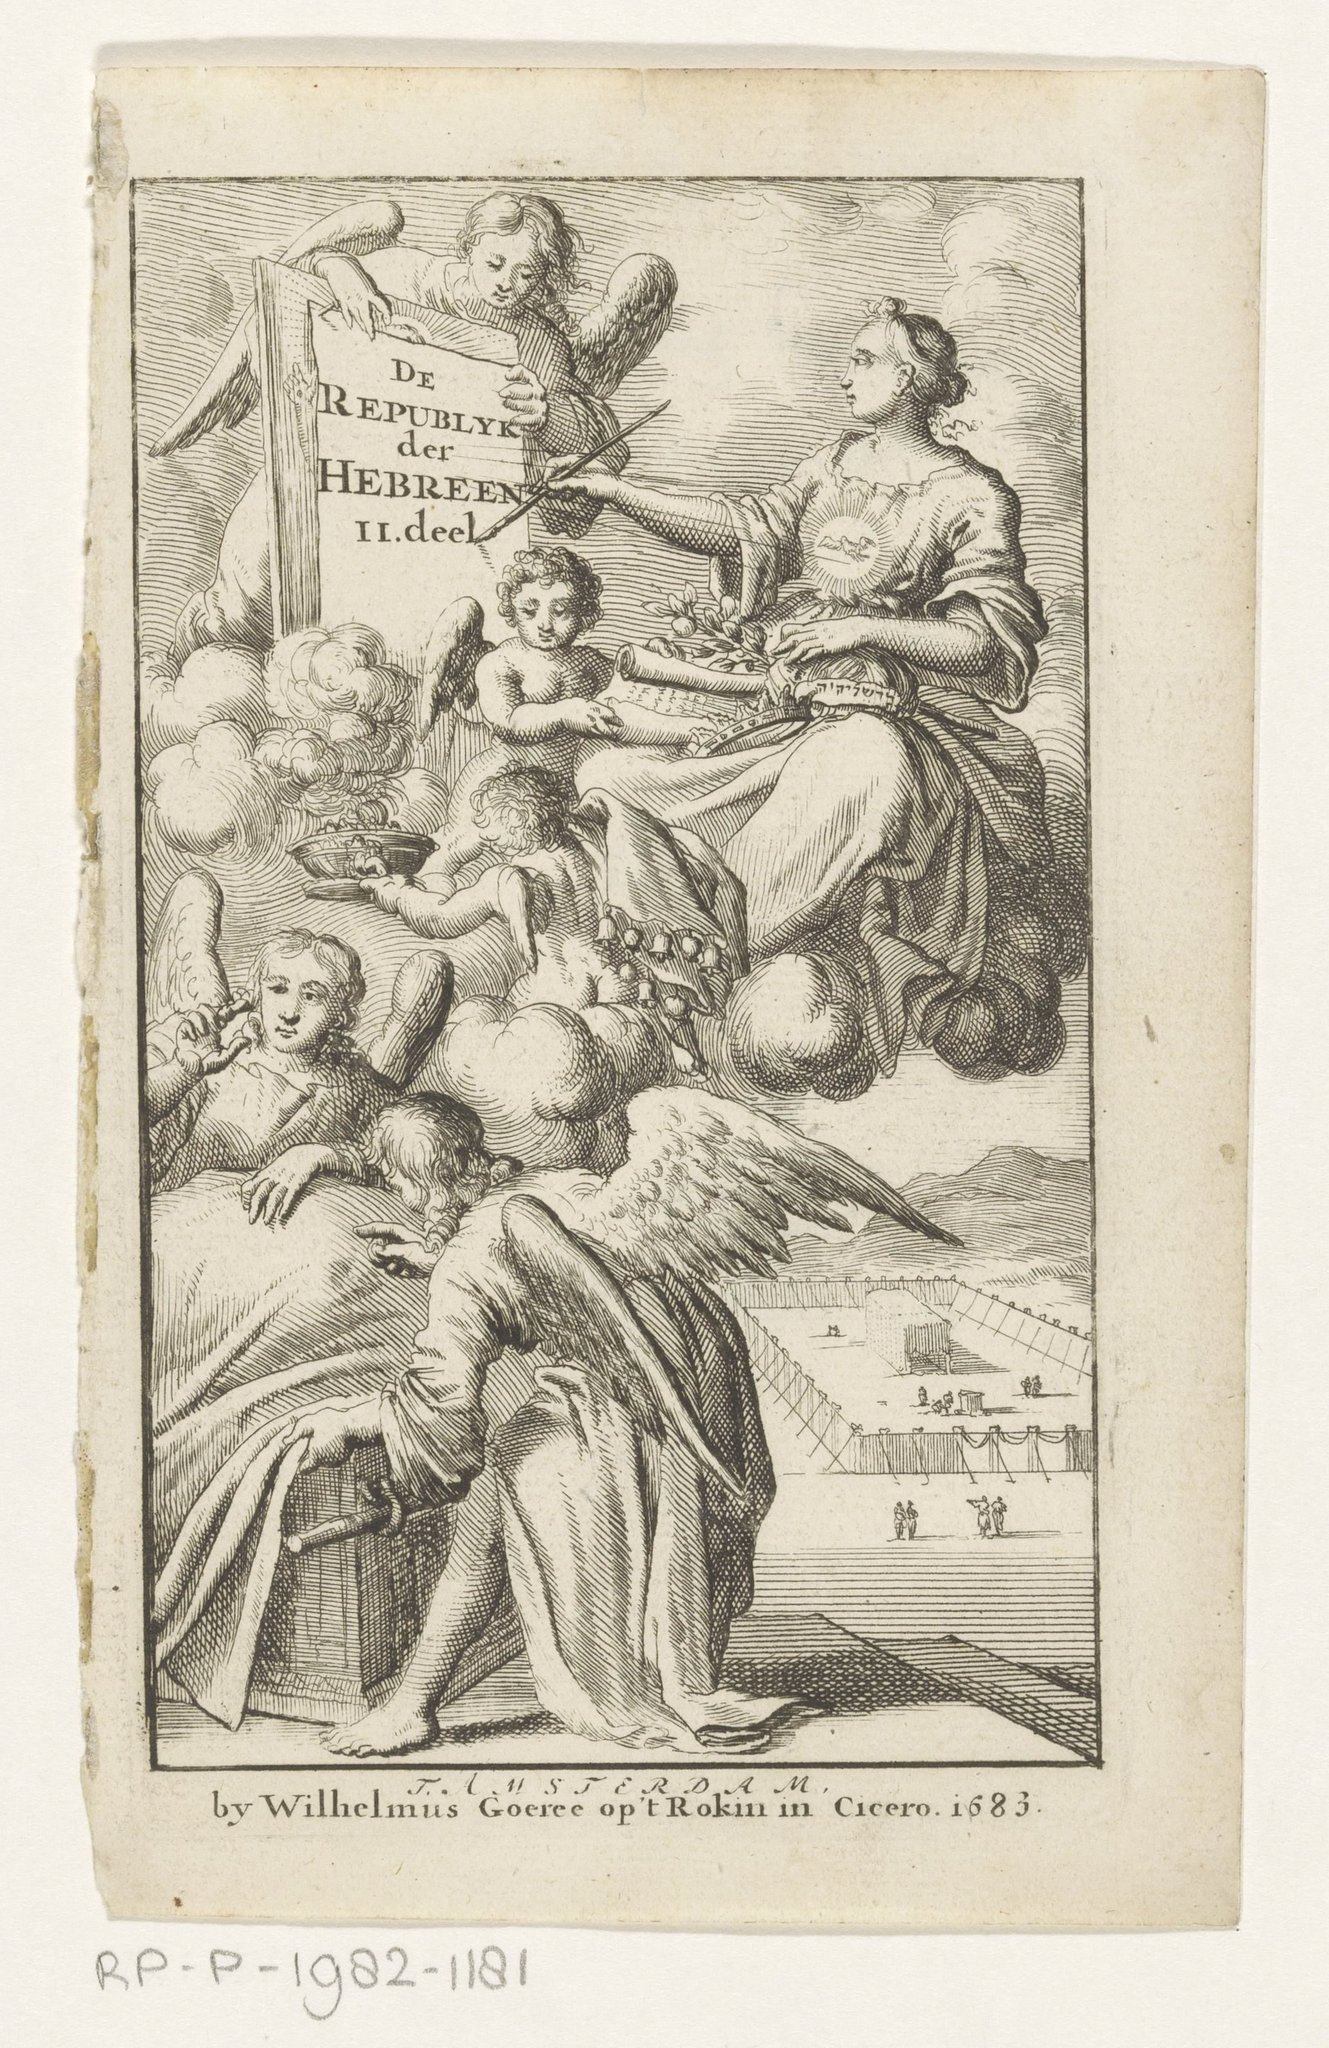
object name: titelblad, titelpagina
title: Allegorische vrouwenfiguur beschildert in de wolken een paneel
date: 1683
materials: paper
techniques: etching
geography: amsterdam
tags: ark of the covenant ~ jewish religion, painting (including book-illumination, miniature-painting), angels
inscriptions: collector's mark: Lugt 2760, collector's mark: Lugt 2228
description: Een allegorische vrouwenfiguur beschildert in de wolken een paneel dat door een engel wordt vastgehouden. Hieronder bewaken twee engelen de Ark des Verbonds.